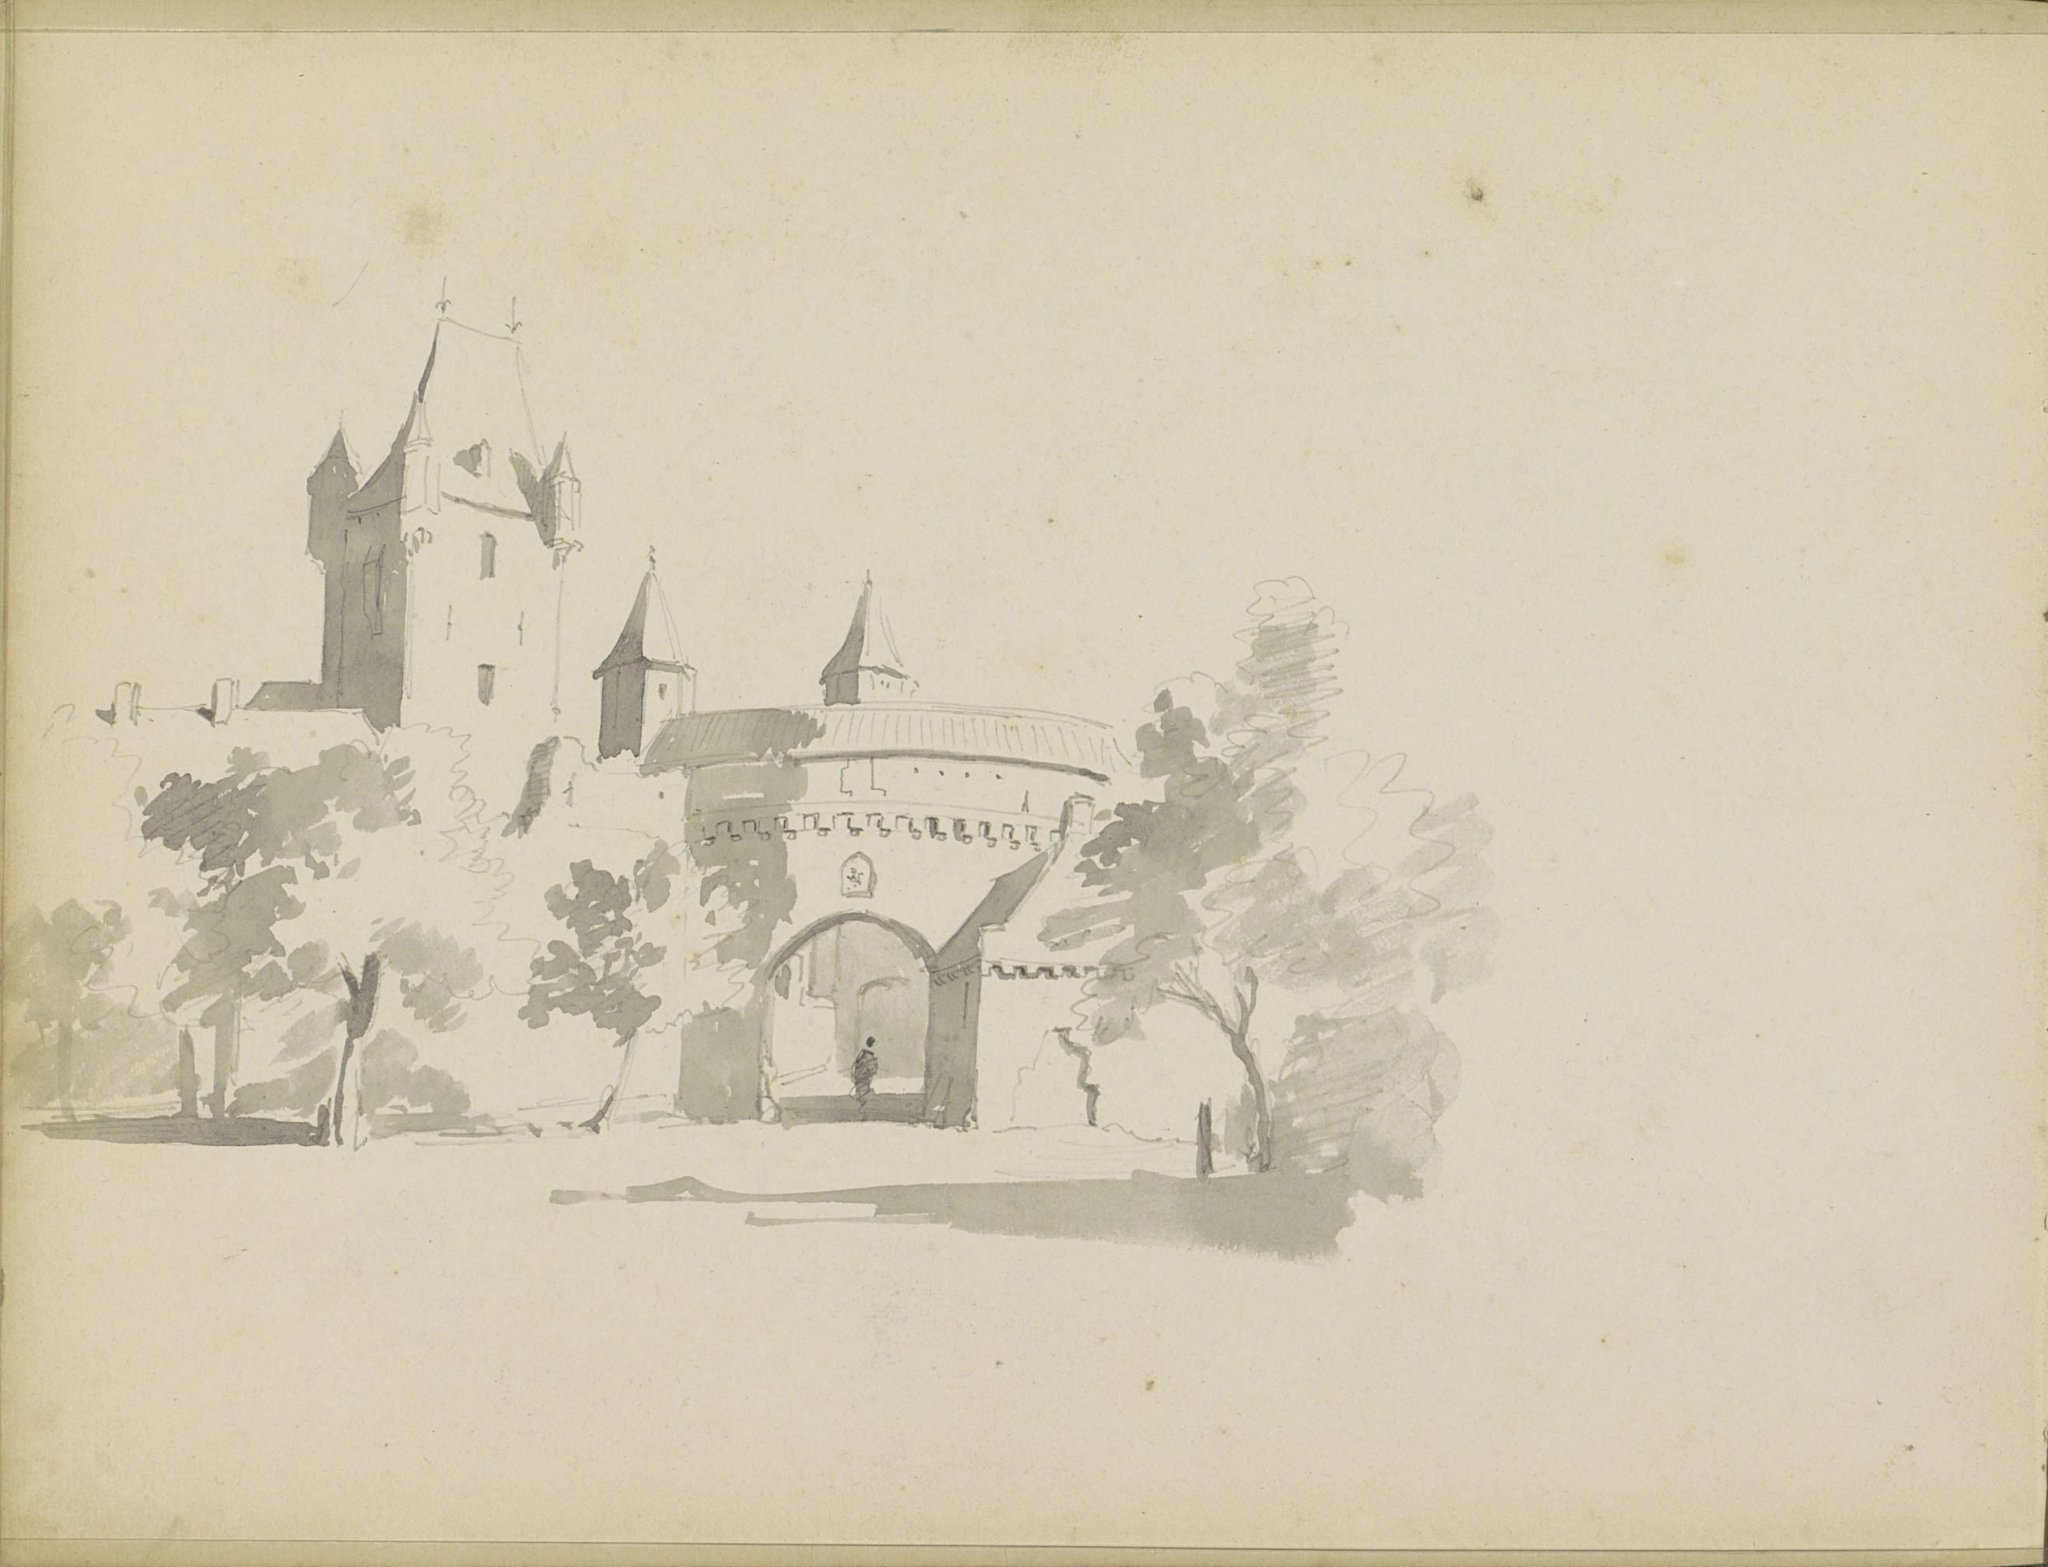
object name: sketchbook leaf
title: Gezicht op een kasteel of buitenplaats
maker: adrianus eversen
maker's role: draughtsman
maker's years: 1818-1897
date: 1828-1897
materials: paper, pencil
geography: netherlands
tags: gate, entrance, landscape with tower or castle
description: Gezicht op een kasteel of buitenplaats met torens. Rechts een figuur onder een poort. Blad 24 verso uit een schetsboek met 41 bladen.